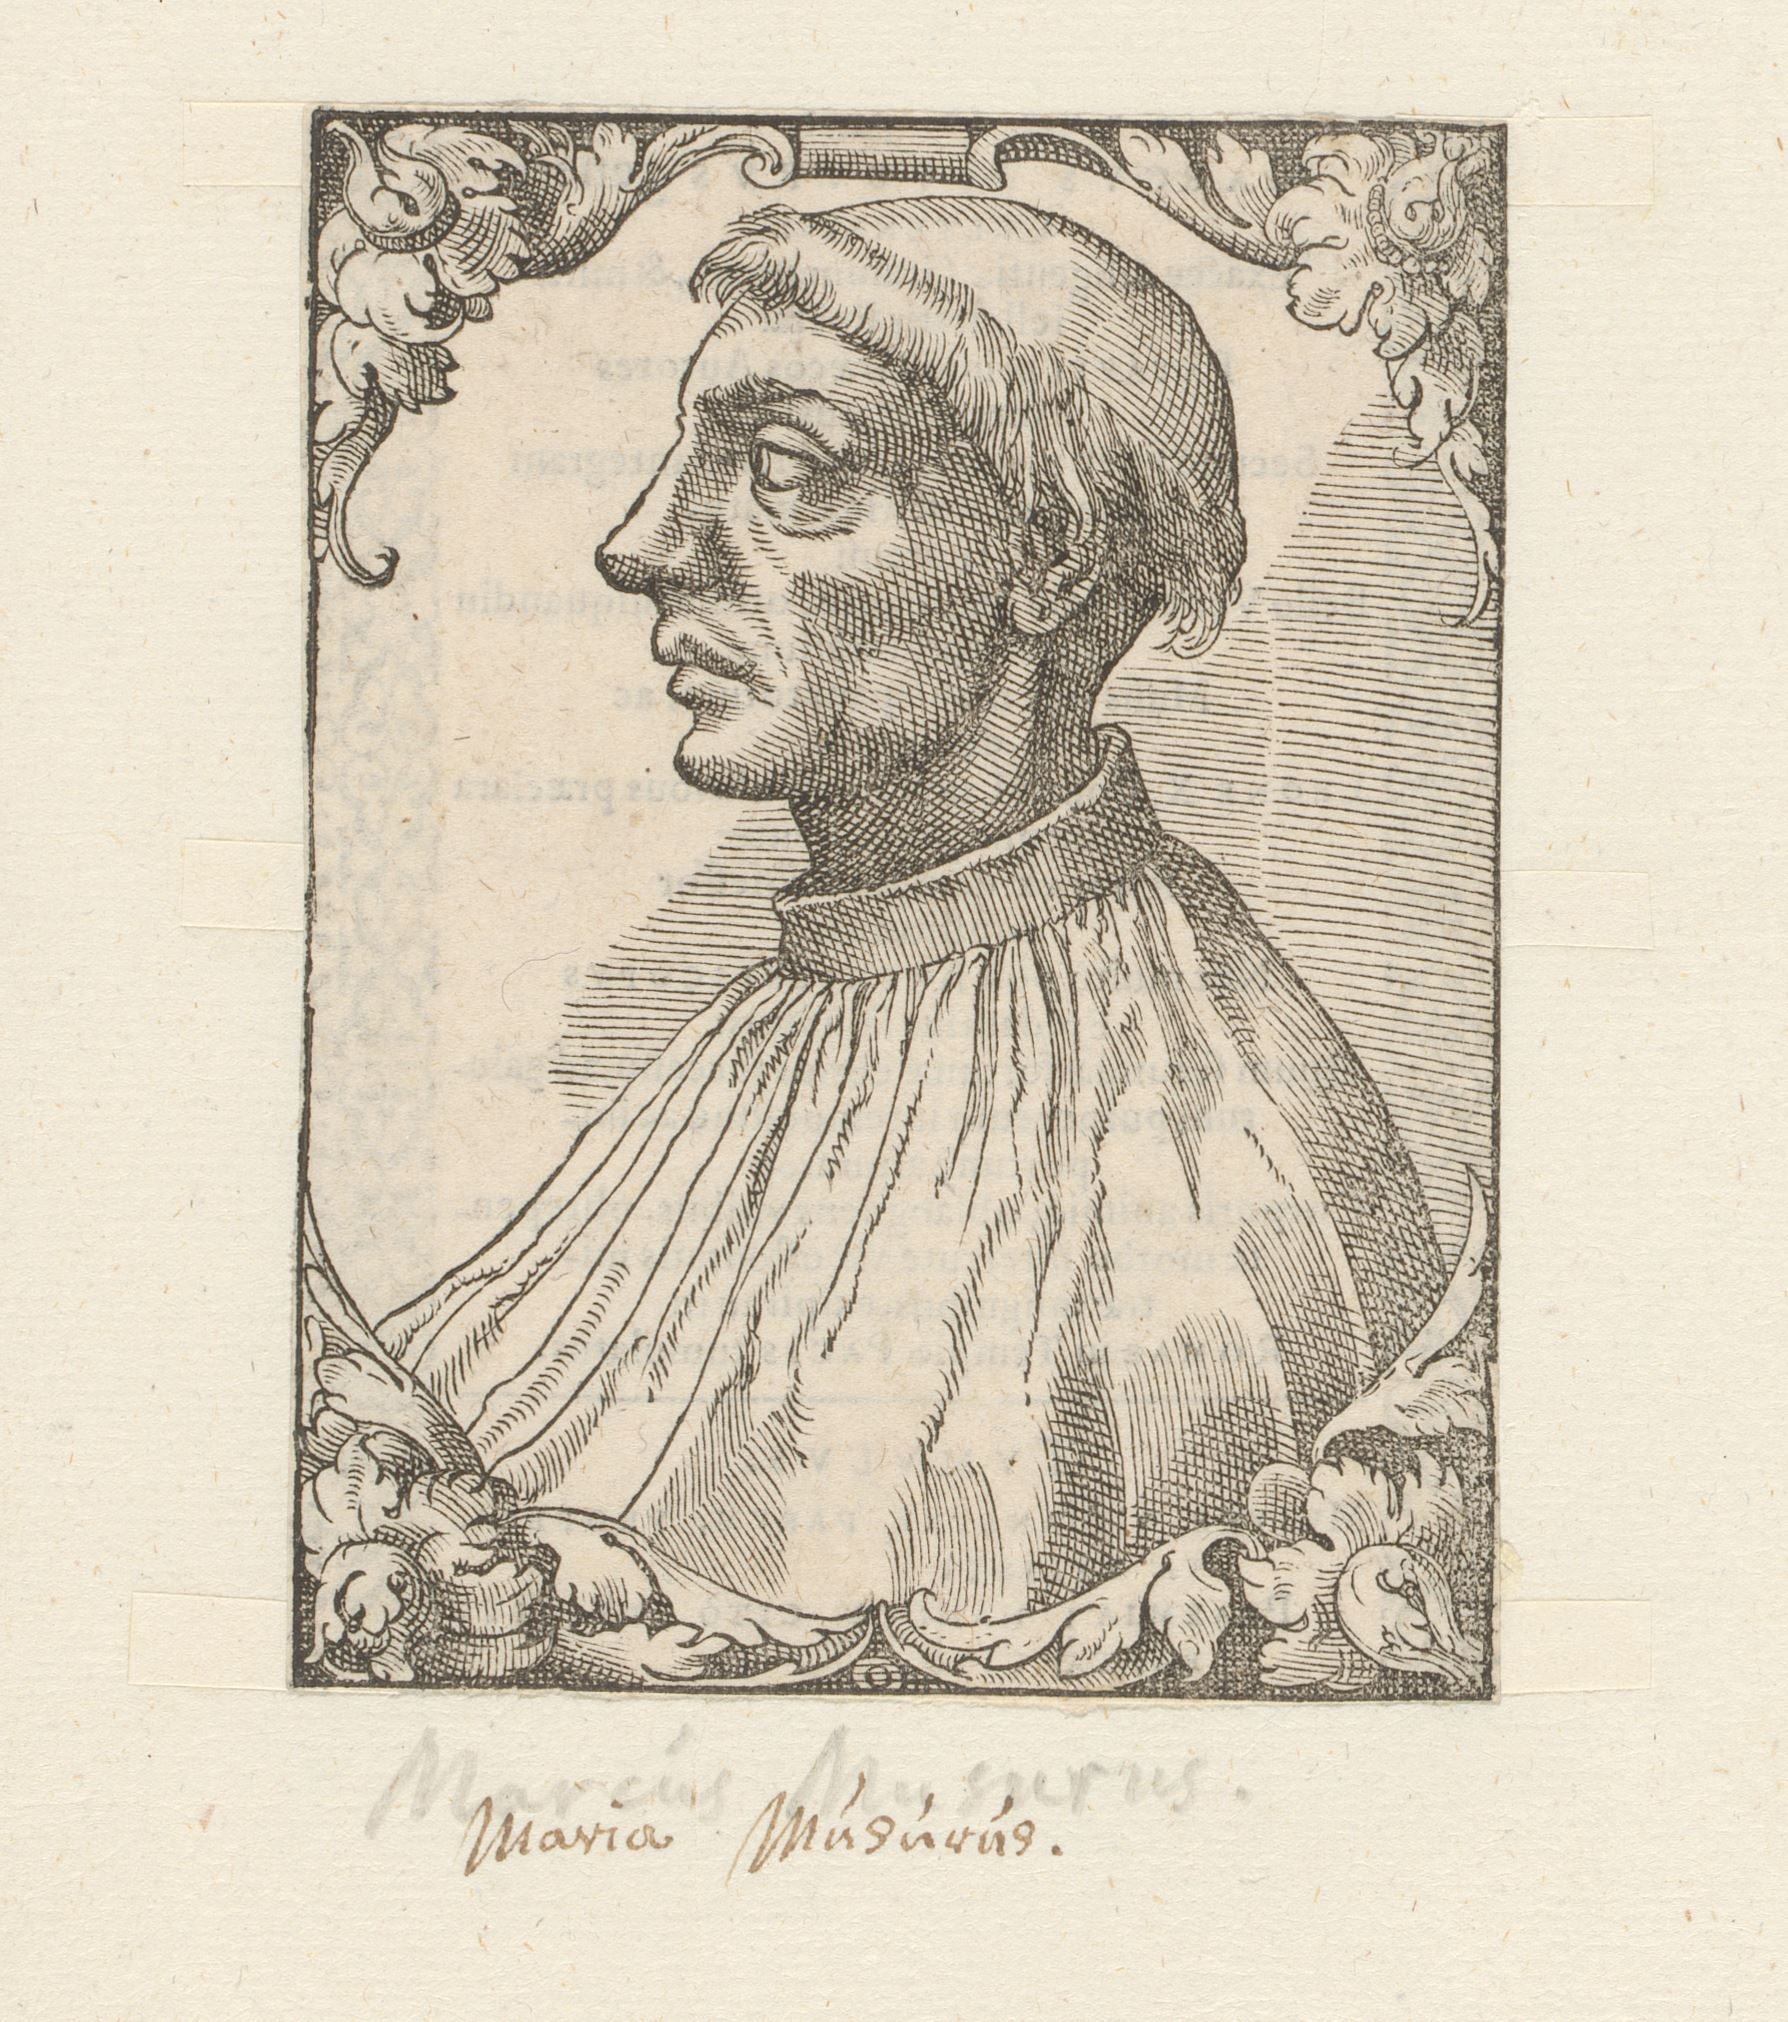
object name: print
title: Portret van Marcus Musurus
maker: Anonymous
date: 1549-1577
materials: paper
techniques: letterpress printing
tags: rome, further education (+ portrait of teacher, professor), historical persons, writer, poet, author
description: Prent gebruikt in: Giovio, Paolo. Elogia Virorum literis illustrium (...). Bazel: Peter Perna, 1577.